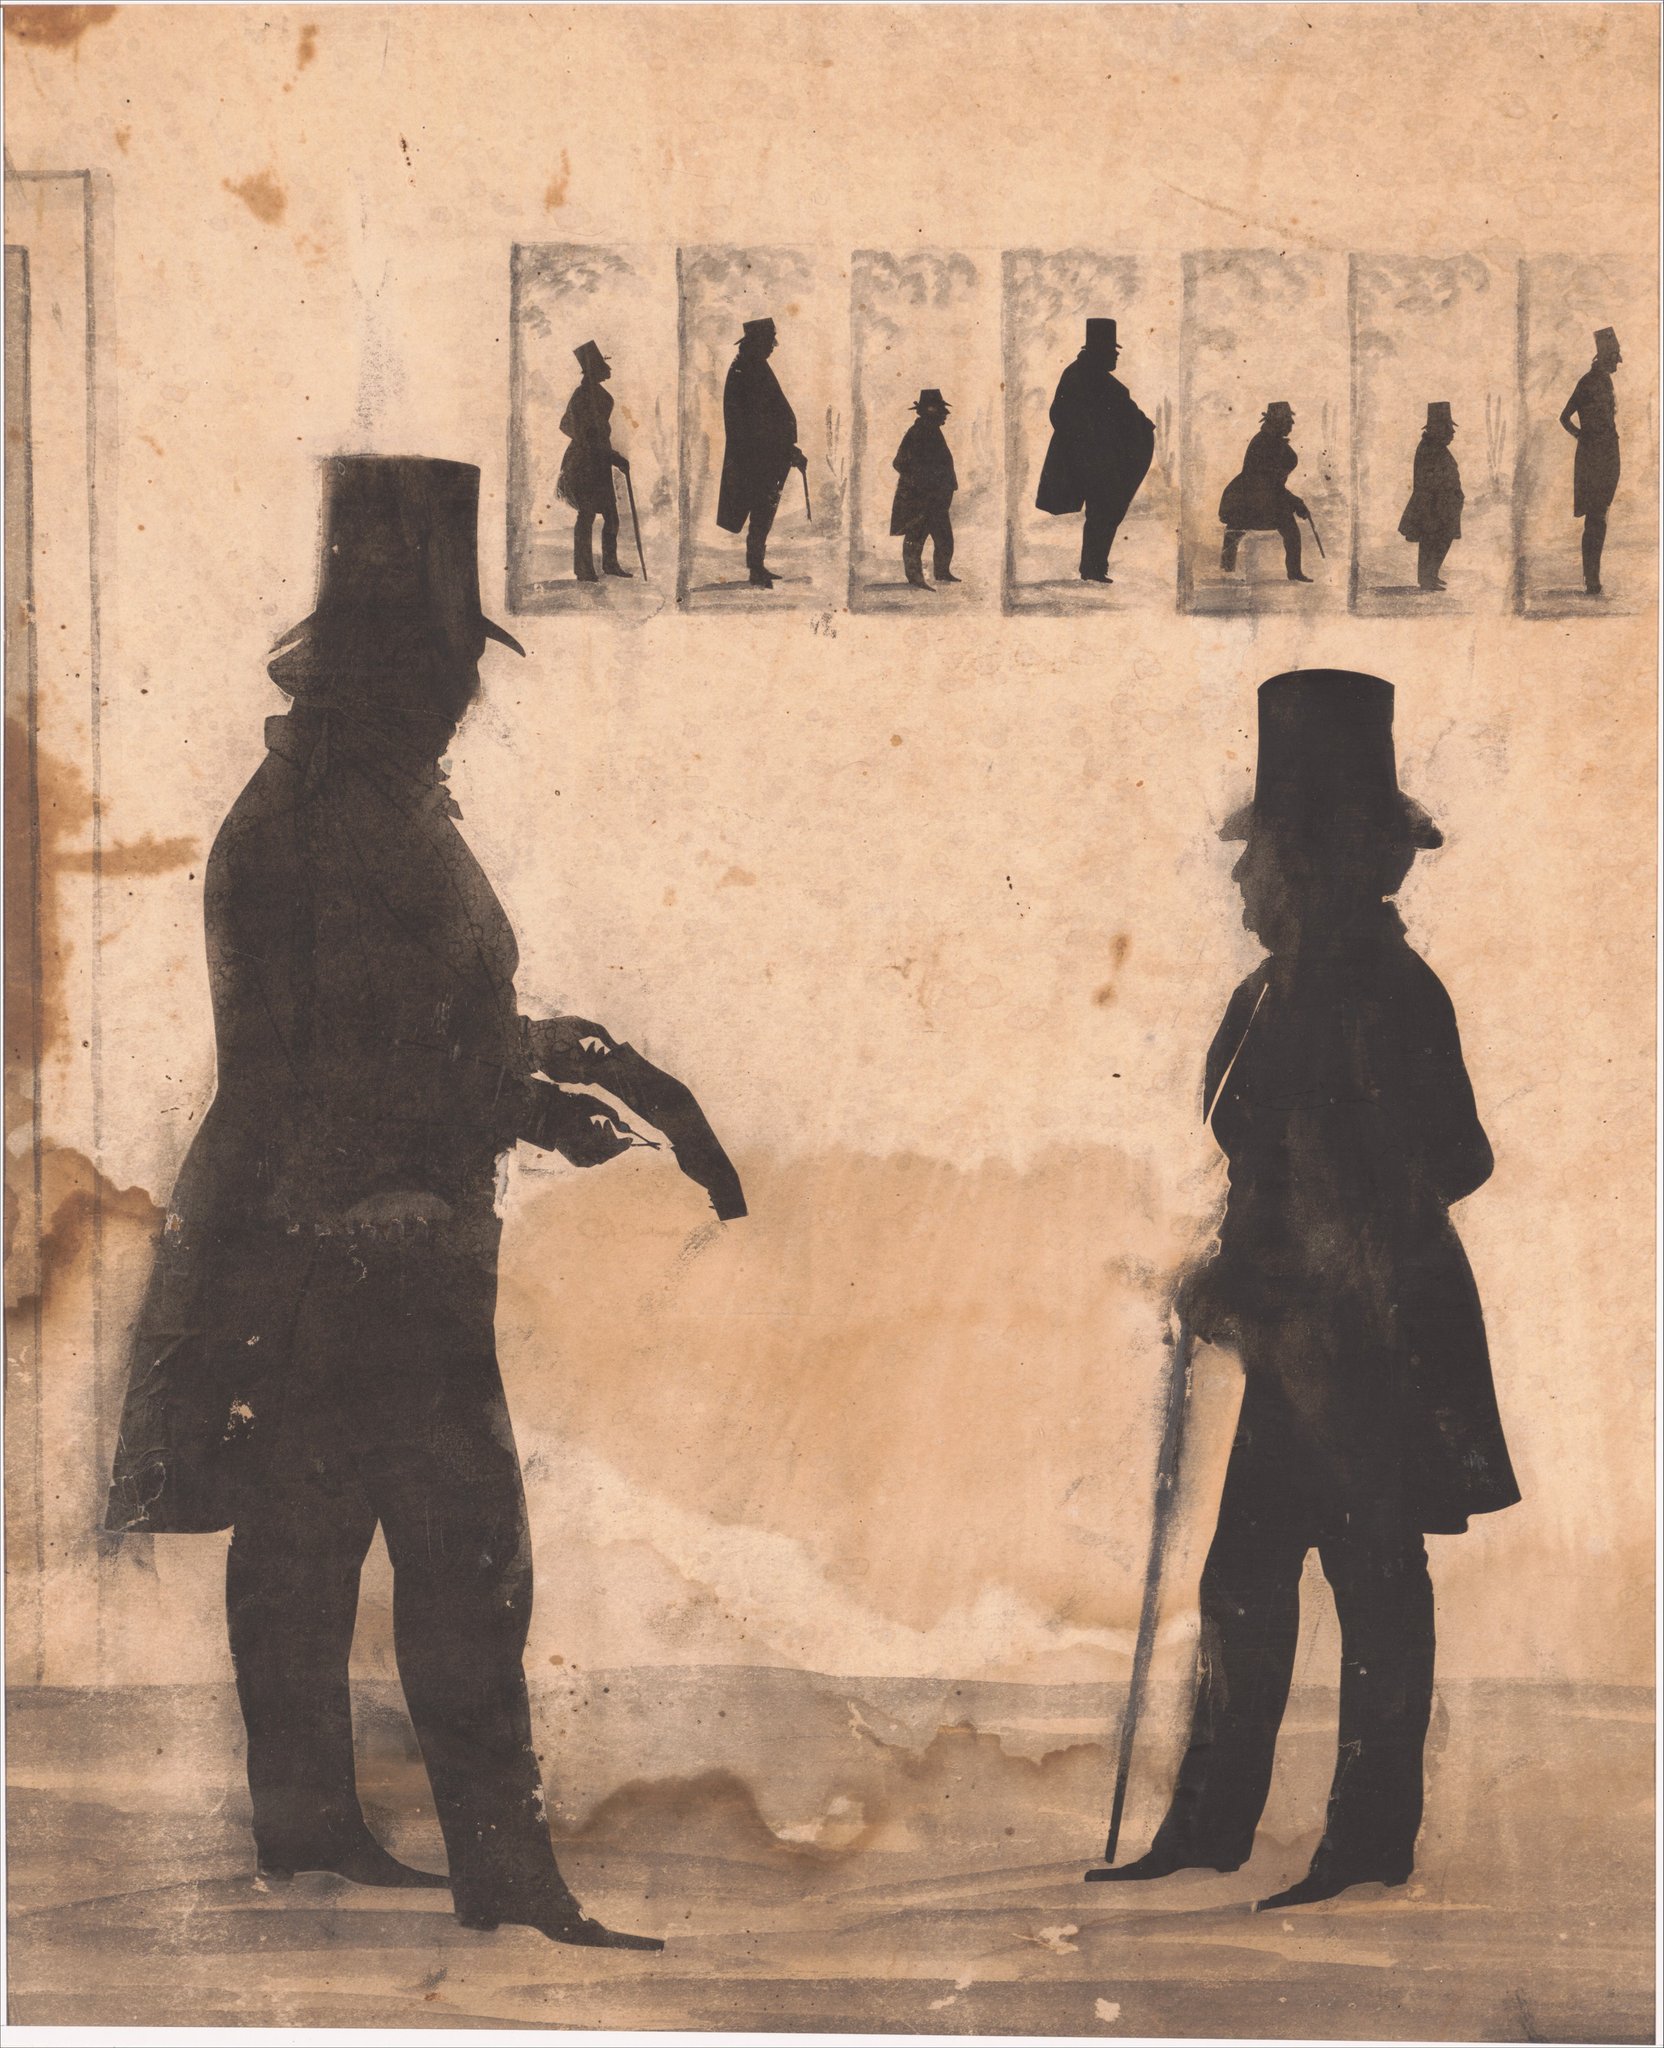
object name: cut paper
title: Two Men, One Cutting a Silhouette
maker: anonymous, american, 19th century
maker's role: artist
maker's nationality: american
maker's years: 1800-1900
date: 1830-1900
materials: ink, paper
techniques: cutting, wash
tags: men